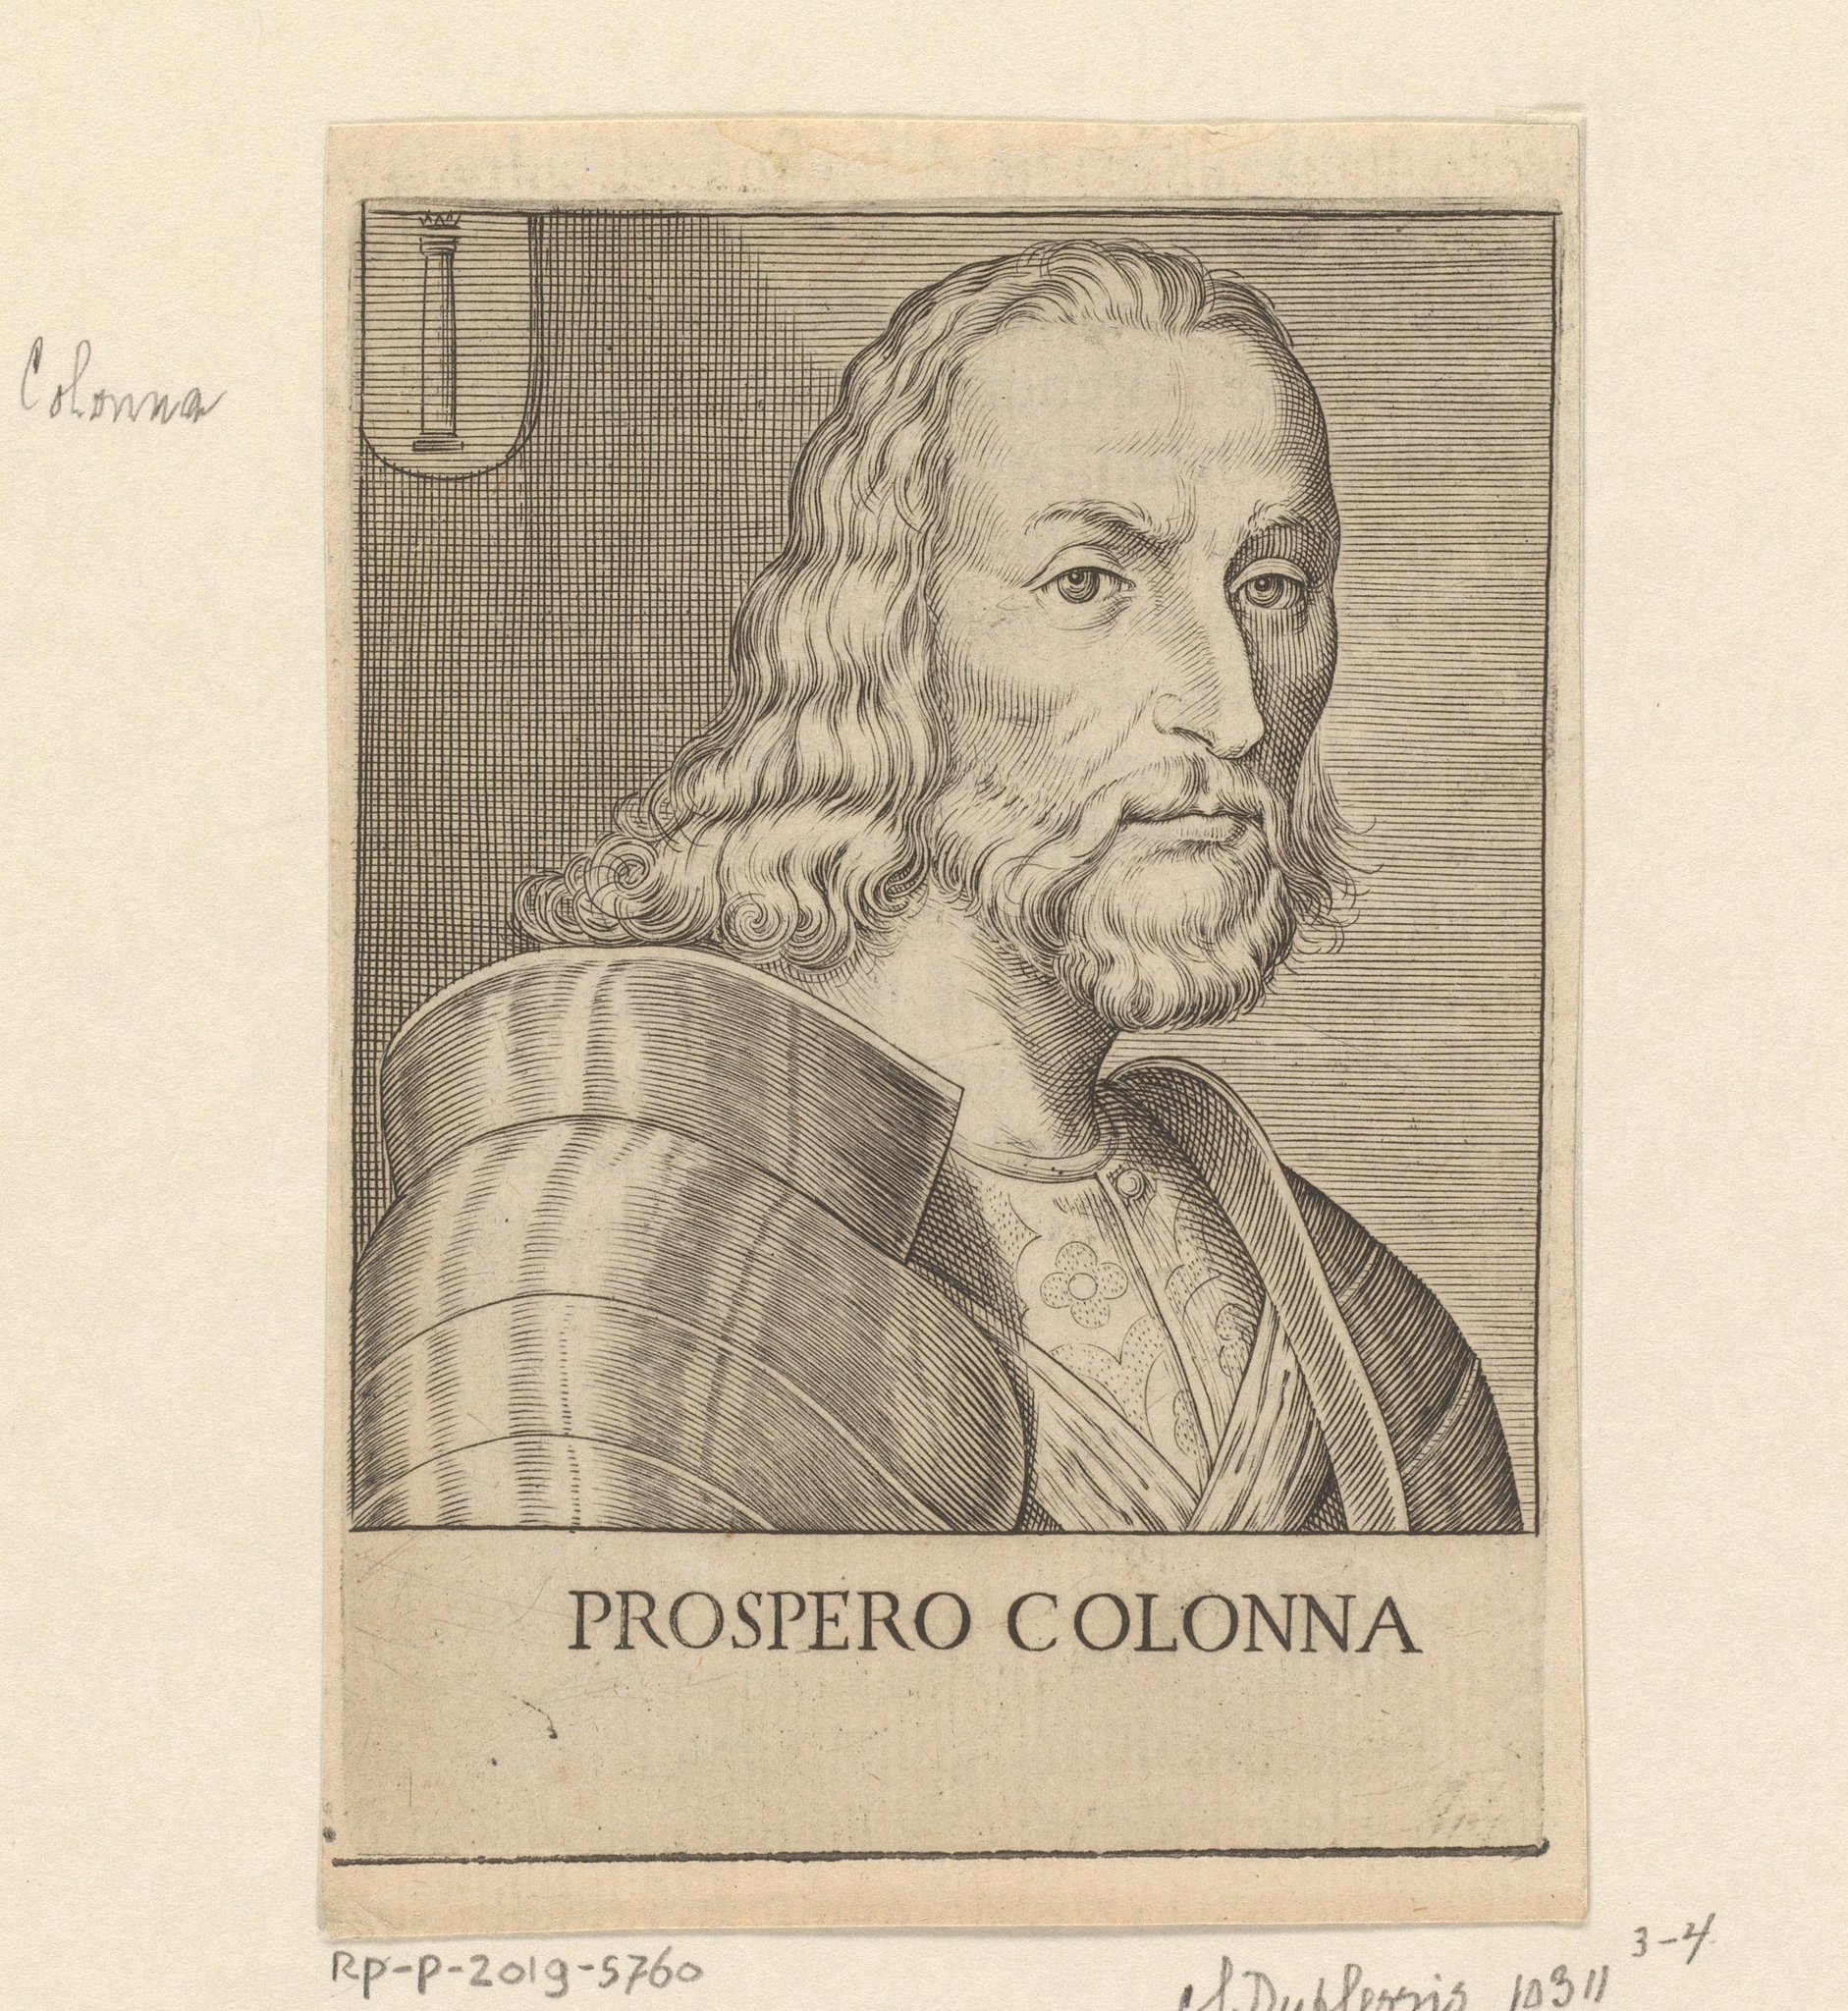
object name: book illustration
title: Prospero Colonna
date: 1646-1647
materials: paper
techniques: engraving, letterpress printing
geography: rome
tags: commander-in-chief, general, marshal, historical persons, armorial bearing, heraldry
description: Prent uit: Ritratti et elogii di capitani Illustri. Che ne'secoli moderni hanno gloriosamente guerreggiato. Rome: Filippo de'Rossi en Vitale Mascardi, 1646, p. 245. Prent ook gebruikt in dezelfde editie van 1647. Eerdere staten van prent in ieder geval gebruikt in: Ritratti et elogii di capitani Illustri. Rome: Pompilio Totti en Andrea Fei, 1635. En in: Ritratti di cento capitani illustri con li lor Fatti in guerra (…), Rome: Domenico Gigliotti, 1596.